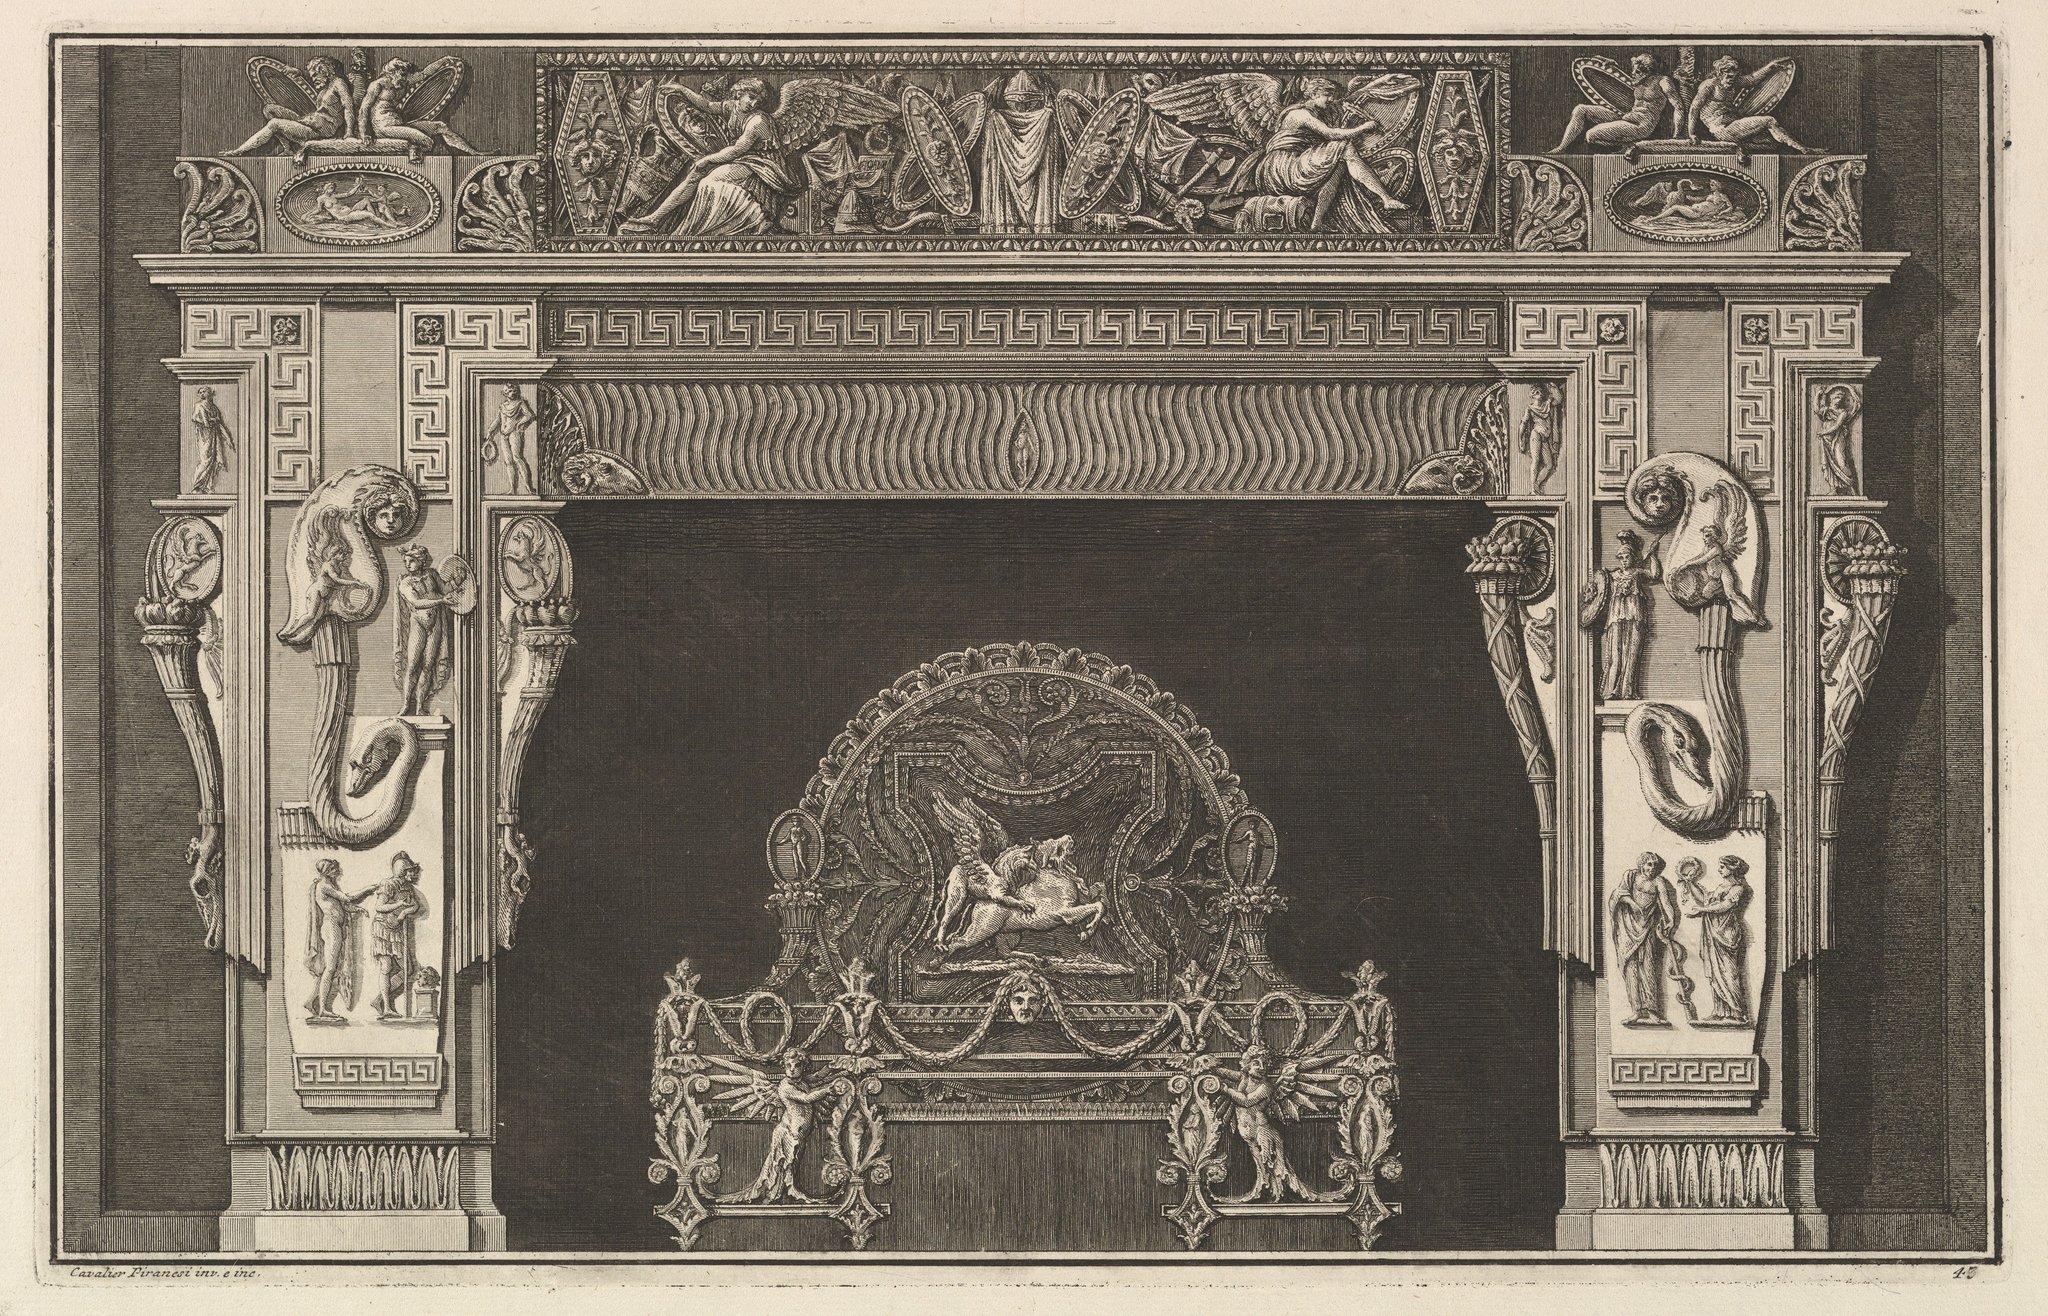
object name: print ornament architecture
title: Chimneypiece: Frieze of trophies and winged Victories on the lintel, with cornucopias to either side of the jambs decorated with varied reliefs (Ch. décorée d'une grecque), from Diverse Maniere d'adornare i cammini ed ogni altra parte degli edifizi...(Different Ways of ornamenting chimneypieces and all other parts of houses)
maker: giovanni battista piranesi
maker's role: artist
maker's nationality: italian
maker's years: 1720-1778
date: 1769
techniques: etching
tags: ornament,victory